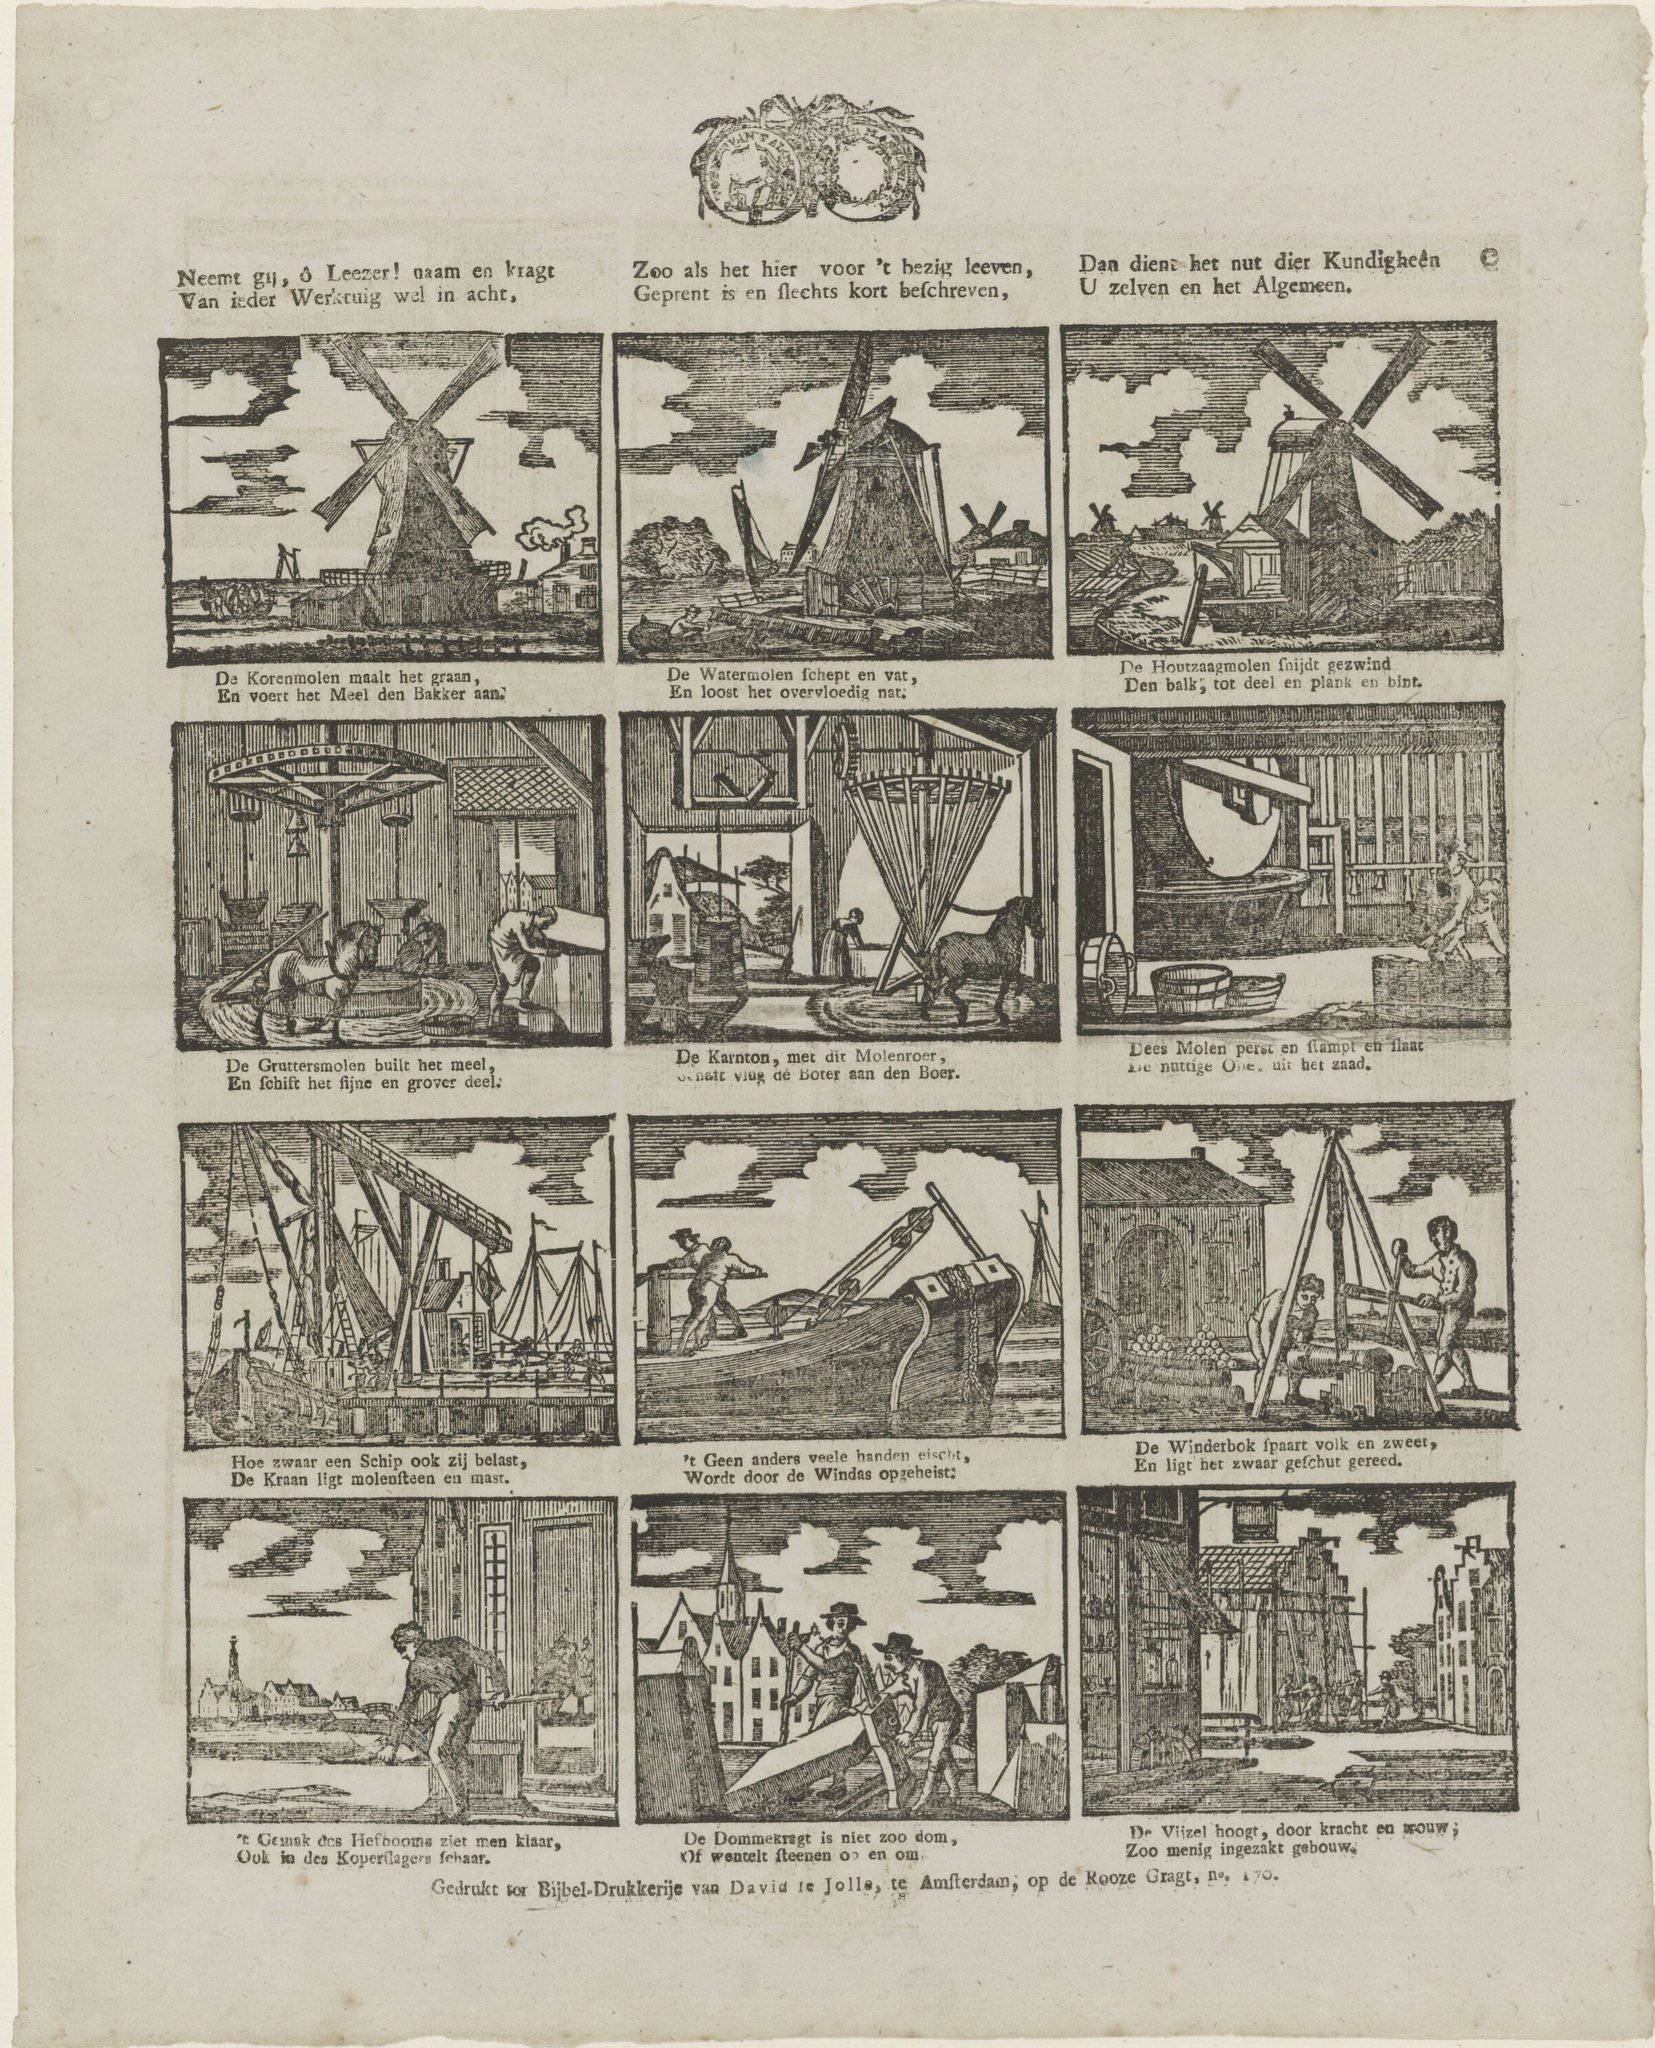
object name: popular print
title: Neemt gij, ô leezer! naam en kragt / Van ieder werktuig wel in acht [(...)]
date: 1814-1820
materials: paper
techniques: letterpress printing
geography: netherlands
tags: machines; parts of machines; tools and appliances, dynamics, kinetics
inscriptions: collector's mark: Lugt 2760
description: Blad met 12 voorstellingen van verschillende werktuigen en machines. Midden boven het zegel van de Maatschappij tot Nut van 't Algemeen. Onder elke afbeelding een onderschrift. Genummerd rechtsboven: C.